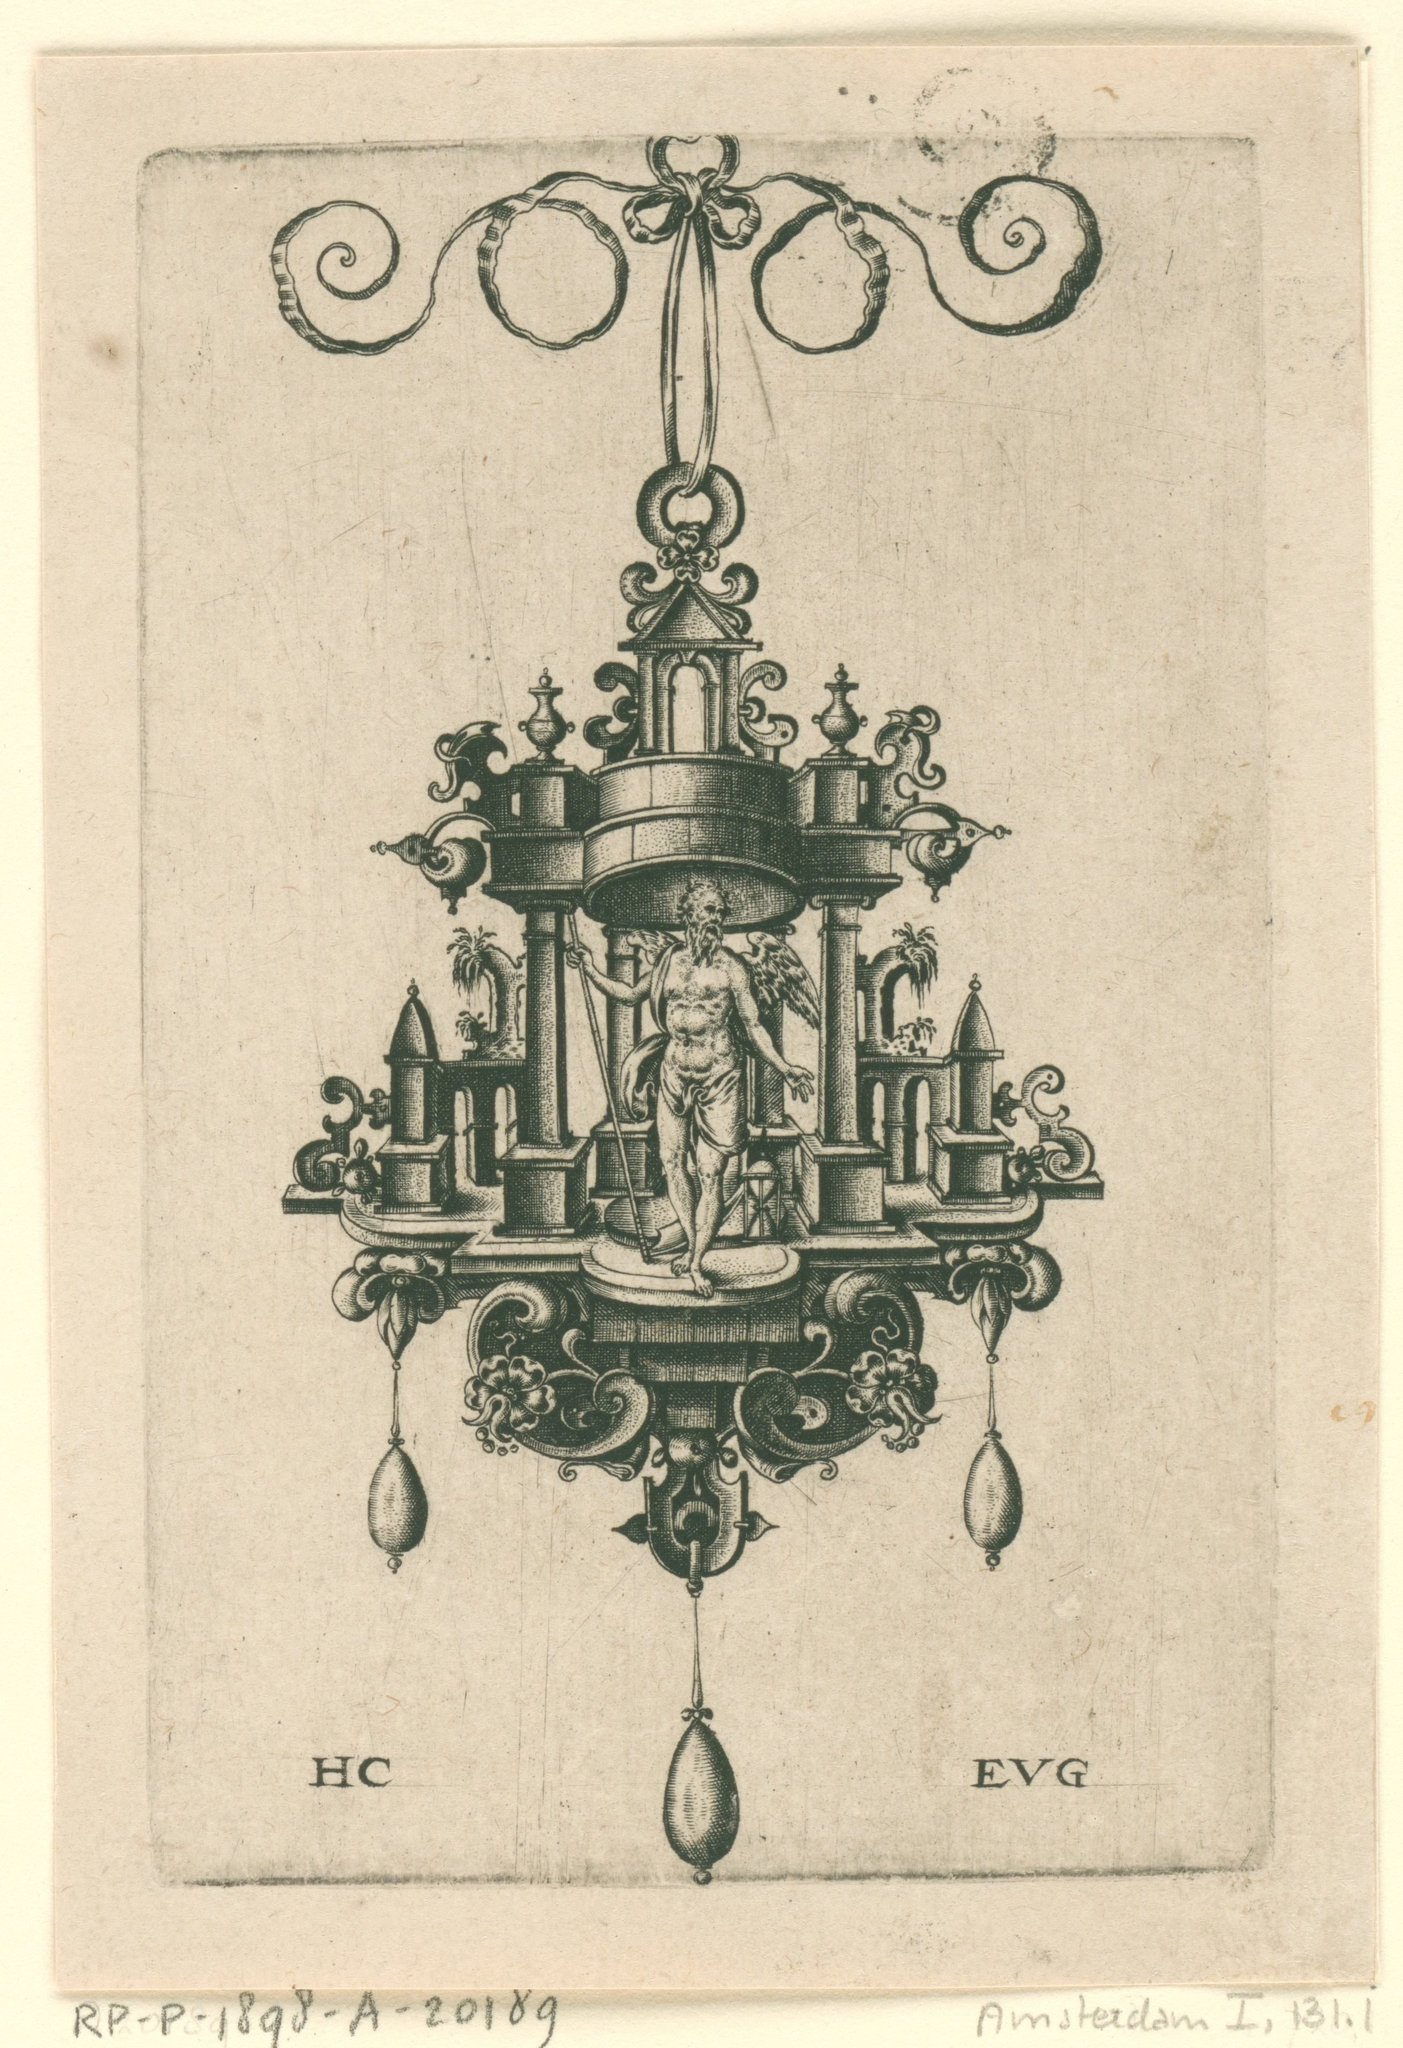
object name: ornament print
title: Hangers. Nissen, gedecoreerd met voluten van rol- en beslagwerk, mascarons, dieren en grotesken.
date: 1555-1576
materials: paper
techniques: engraving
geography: netherlands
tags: pendant, trinket, 'breloque', father time, man with wings and scythe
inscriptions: inscription: ‘6 pl 1940 sxf (?)’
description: Eén van 9 bladen, uit een serie van 12. Op zes bladen zit in de nis een figuur. Aan elke hanger hangen drie parels.